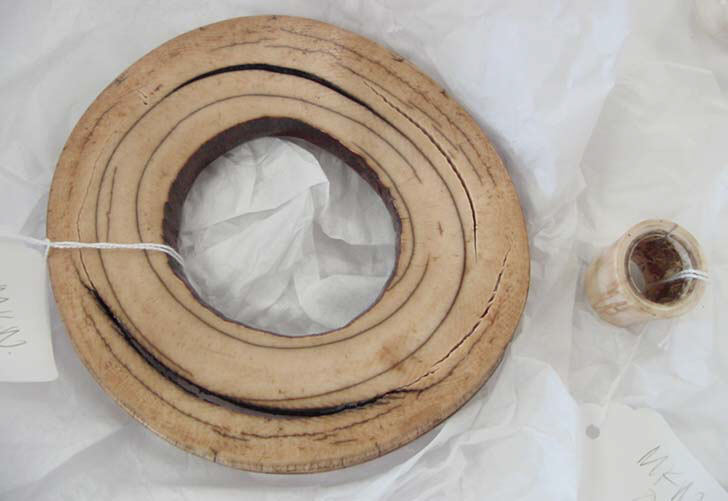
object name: jewelry set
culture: african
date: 1801-1900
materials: ivory